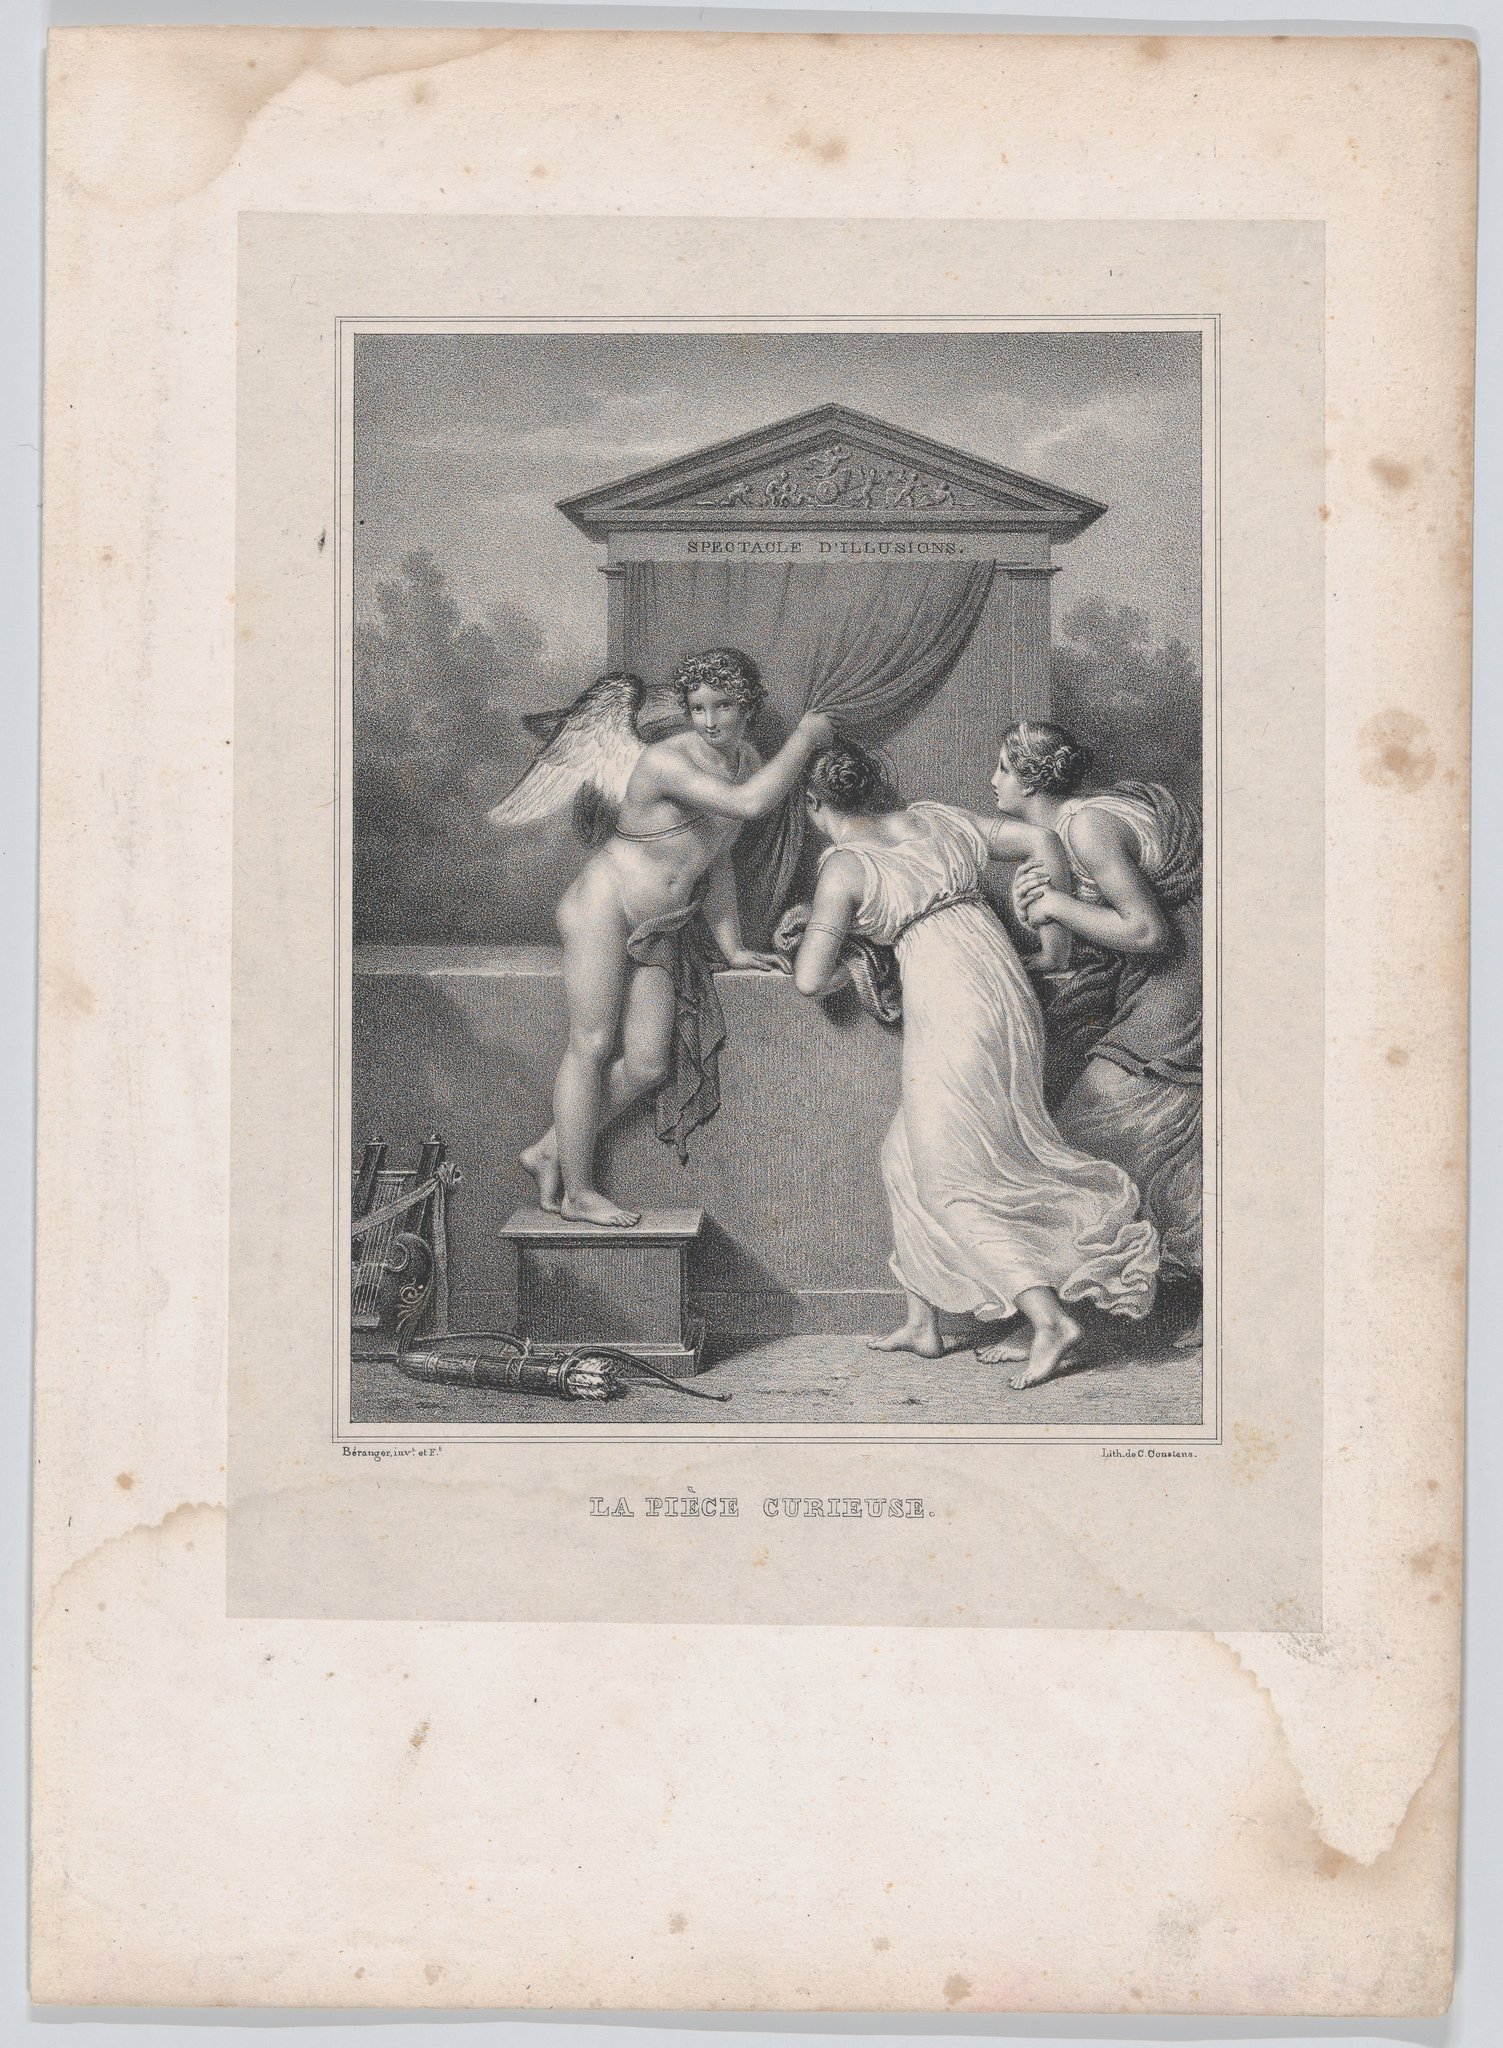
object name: print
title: The Curious Performance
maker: charles-louis constans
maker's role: artist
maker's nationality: french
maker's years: 1803-1840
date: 1803-1840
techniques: lithograph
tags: performance,women